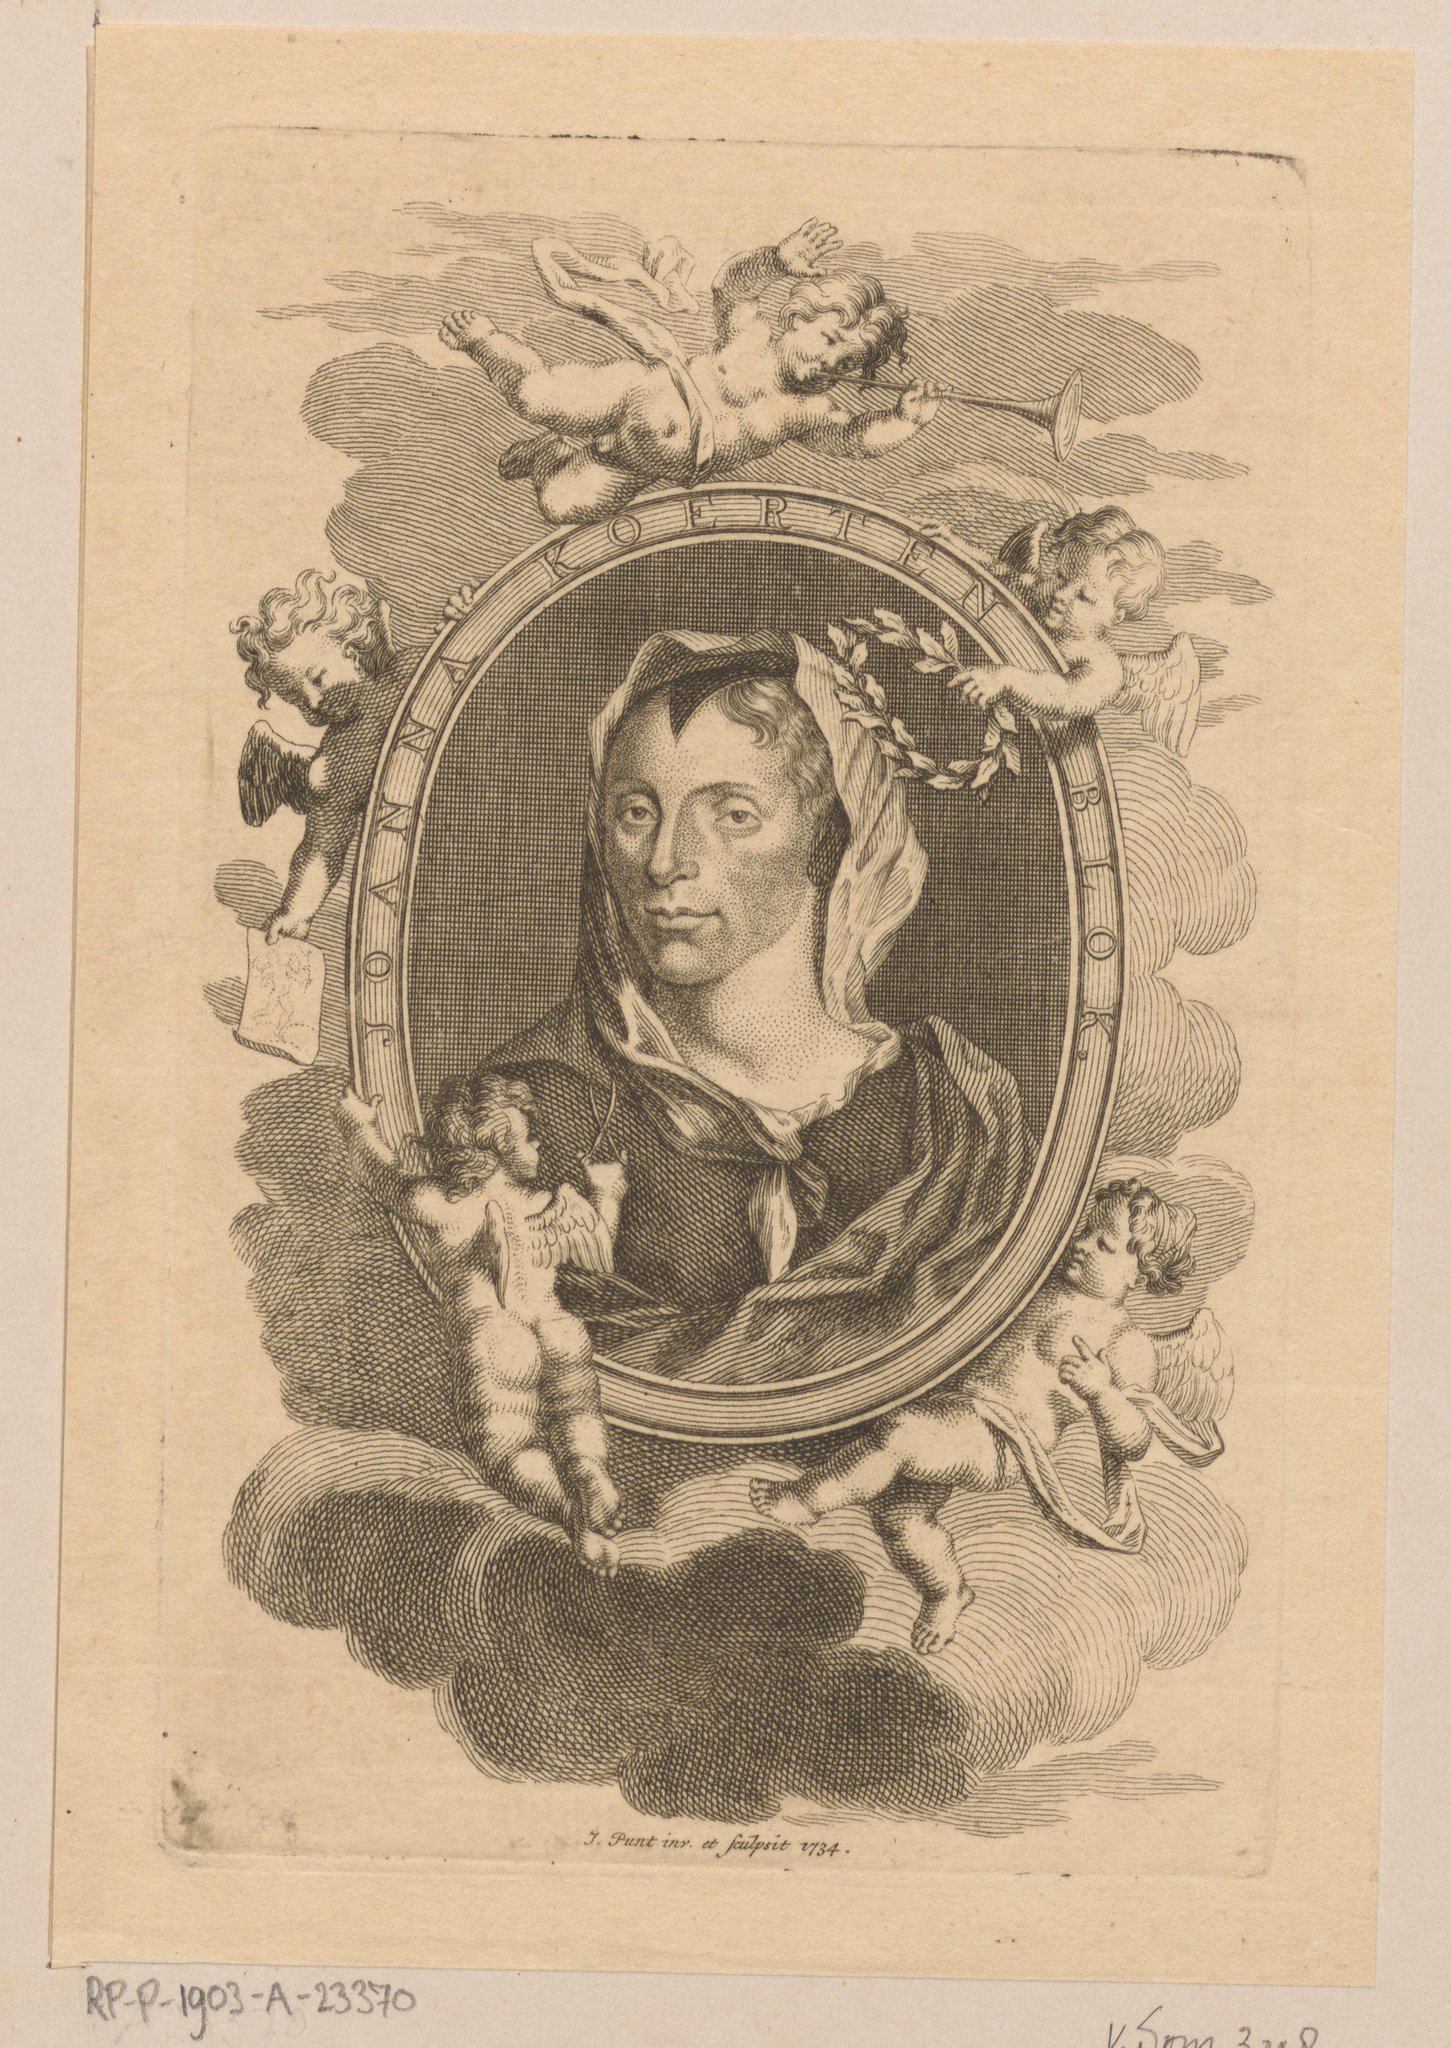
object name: print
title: Portret van Johanna Koerten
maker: jan punt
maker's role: draughtsman, print maker, publisher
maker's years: 1711-1779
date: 1734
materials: paper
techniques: etching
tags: amsterdam, draughtsman, johanna koerten, historical persons - bb - woman, portrait, self-portrait of artist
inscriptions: collector's mark: Lugt 2228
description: Prent mogelijk uit: Het stamboek op de papiere snykunst van Mejuffrouw Joanna Koerten (...). Amsterdam: s.n., 1735.